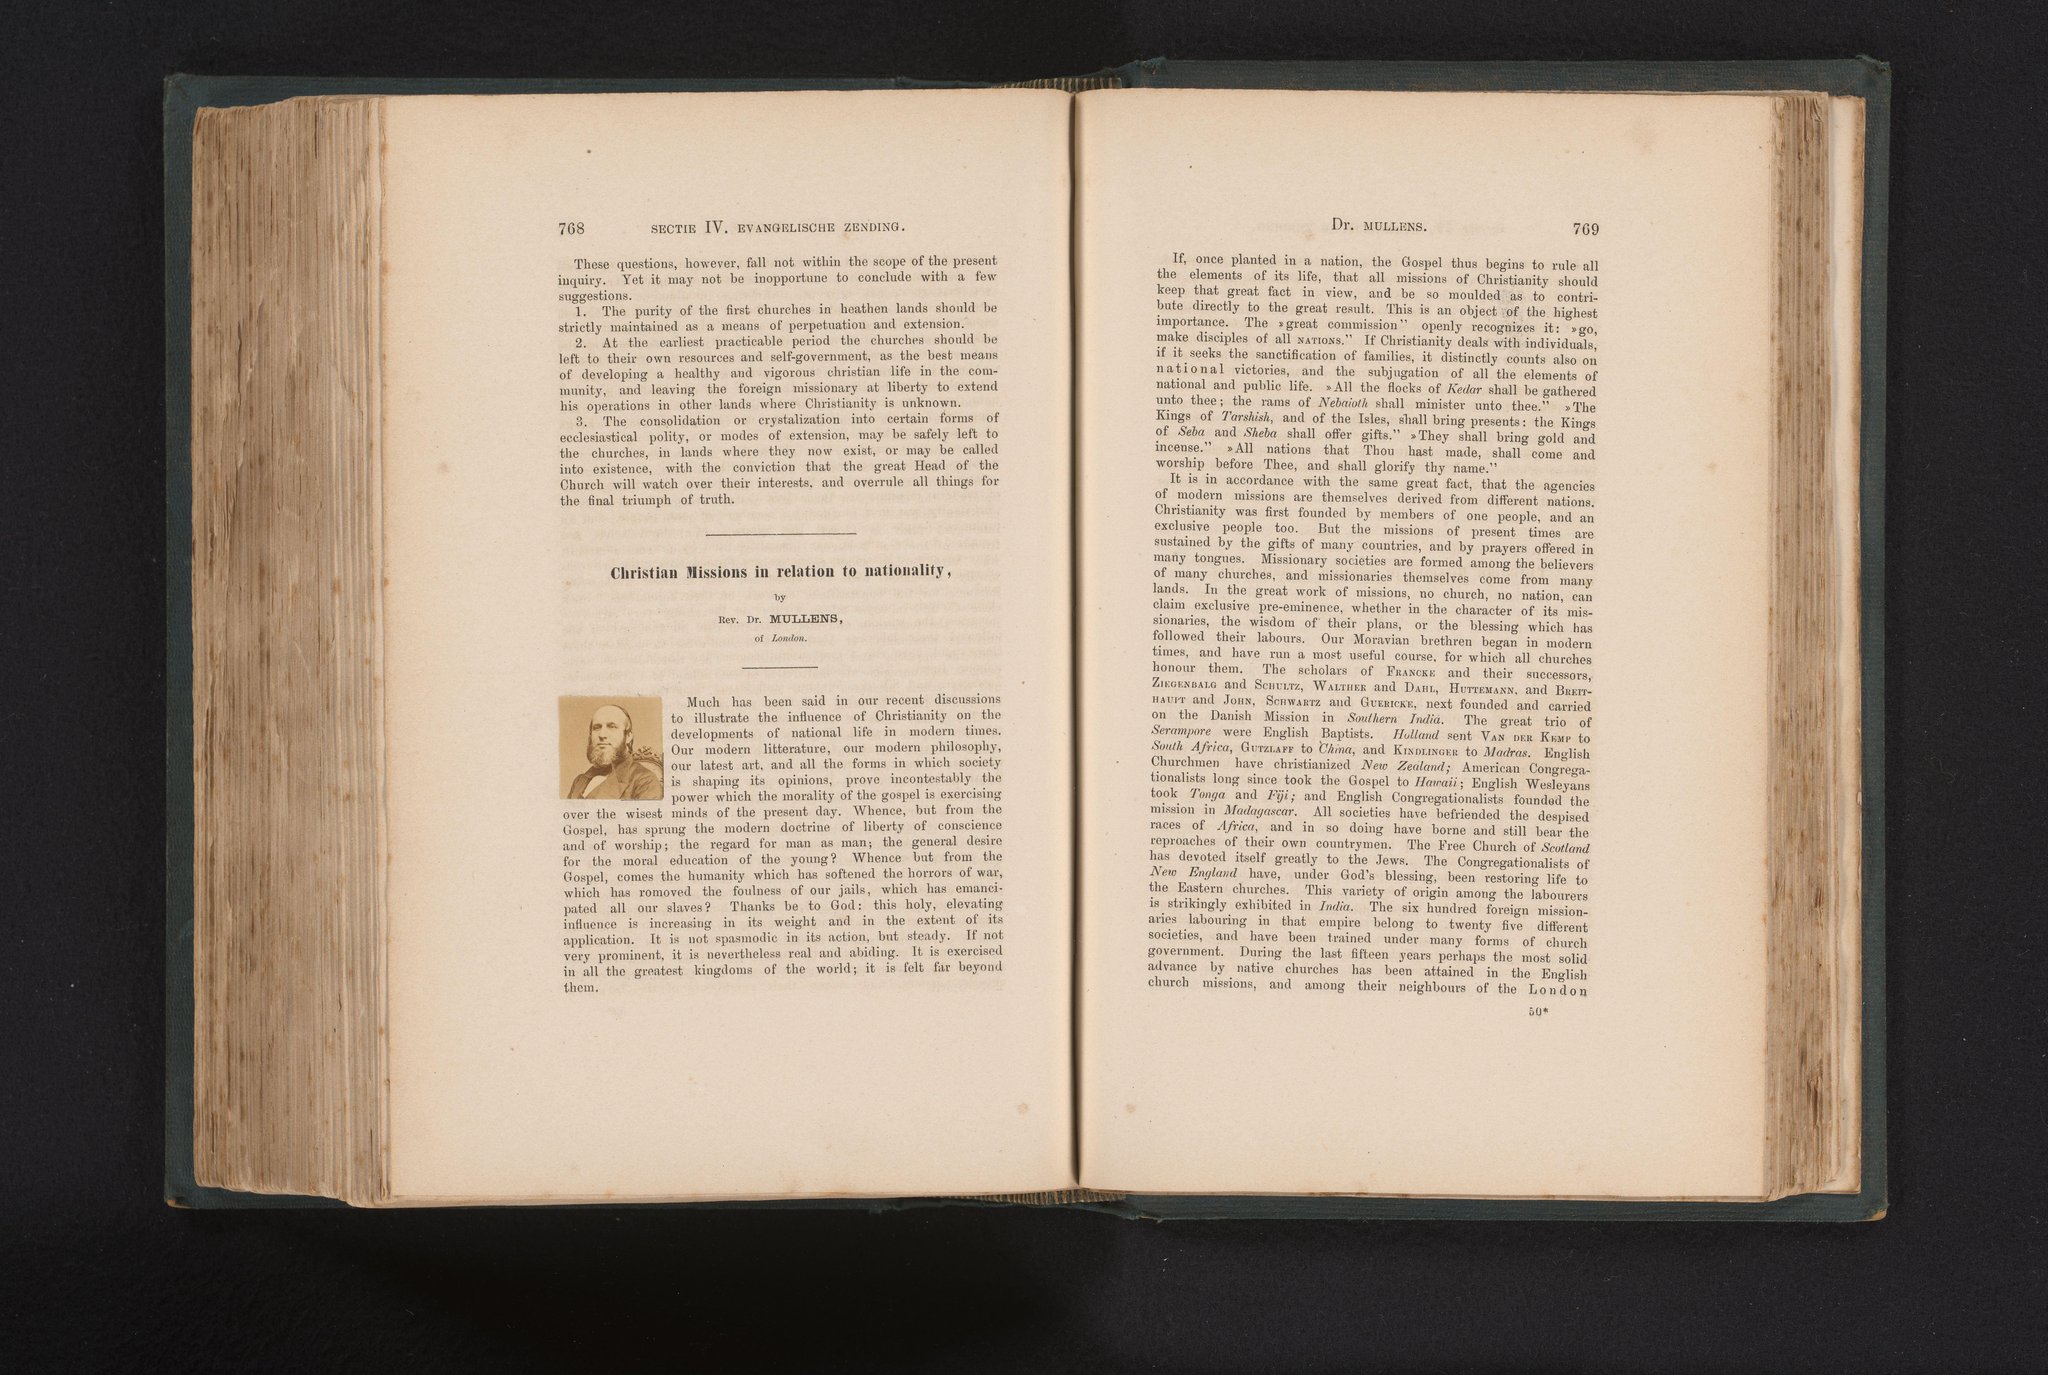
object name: page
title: Portret van Joseph Mullens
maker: Anonymous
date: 1855-1867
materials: paper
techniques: albumen print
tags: adult man, historical persons